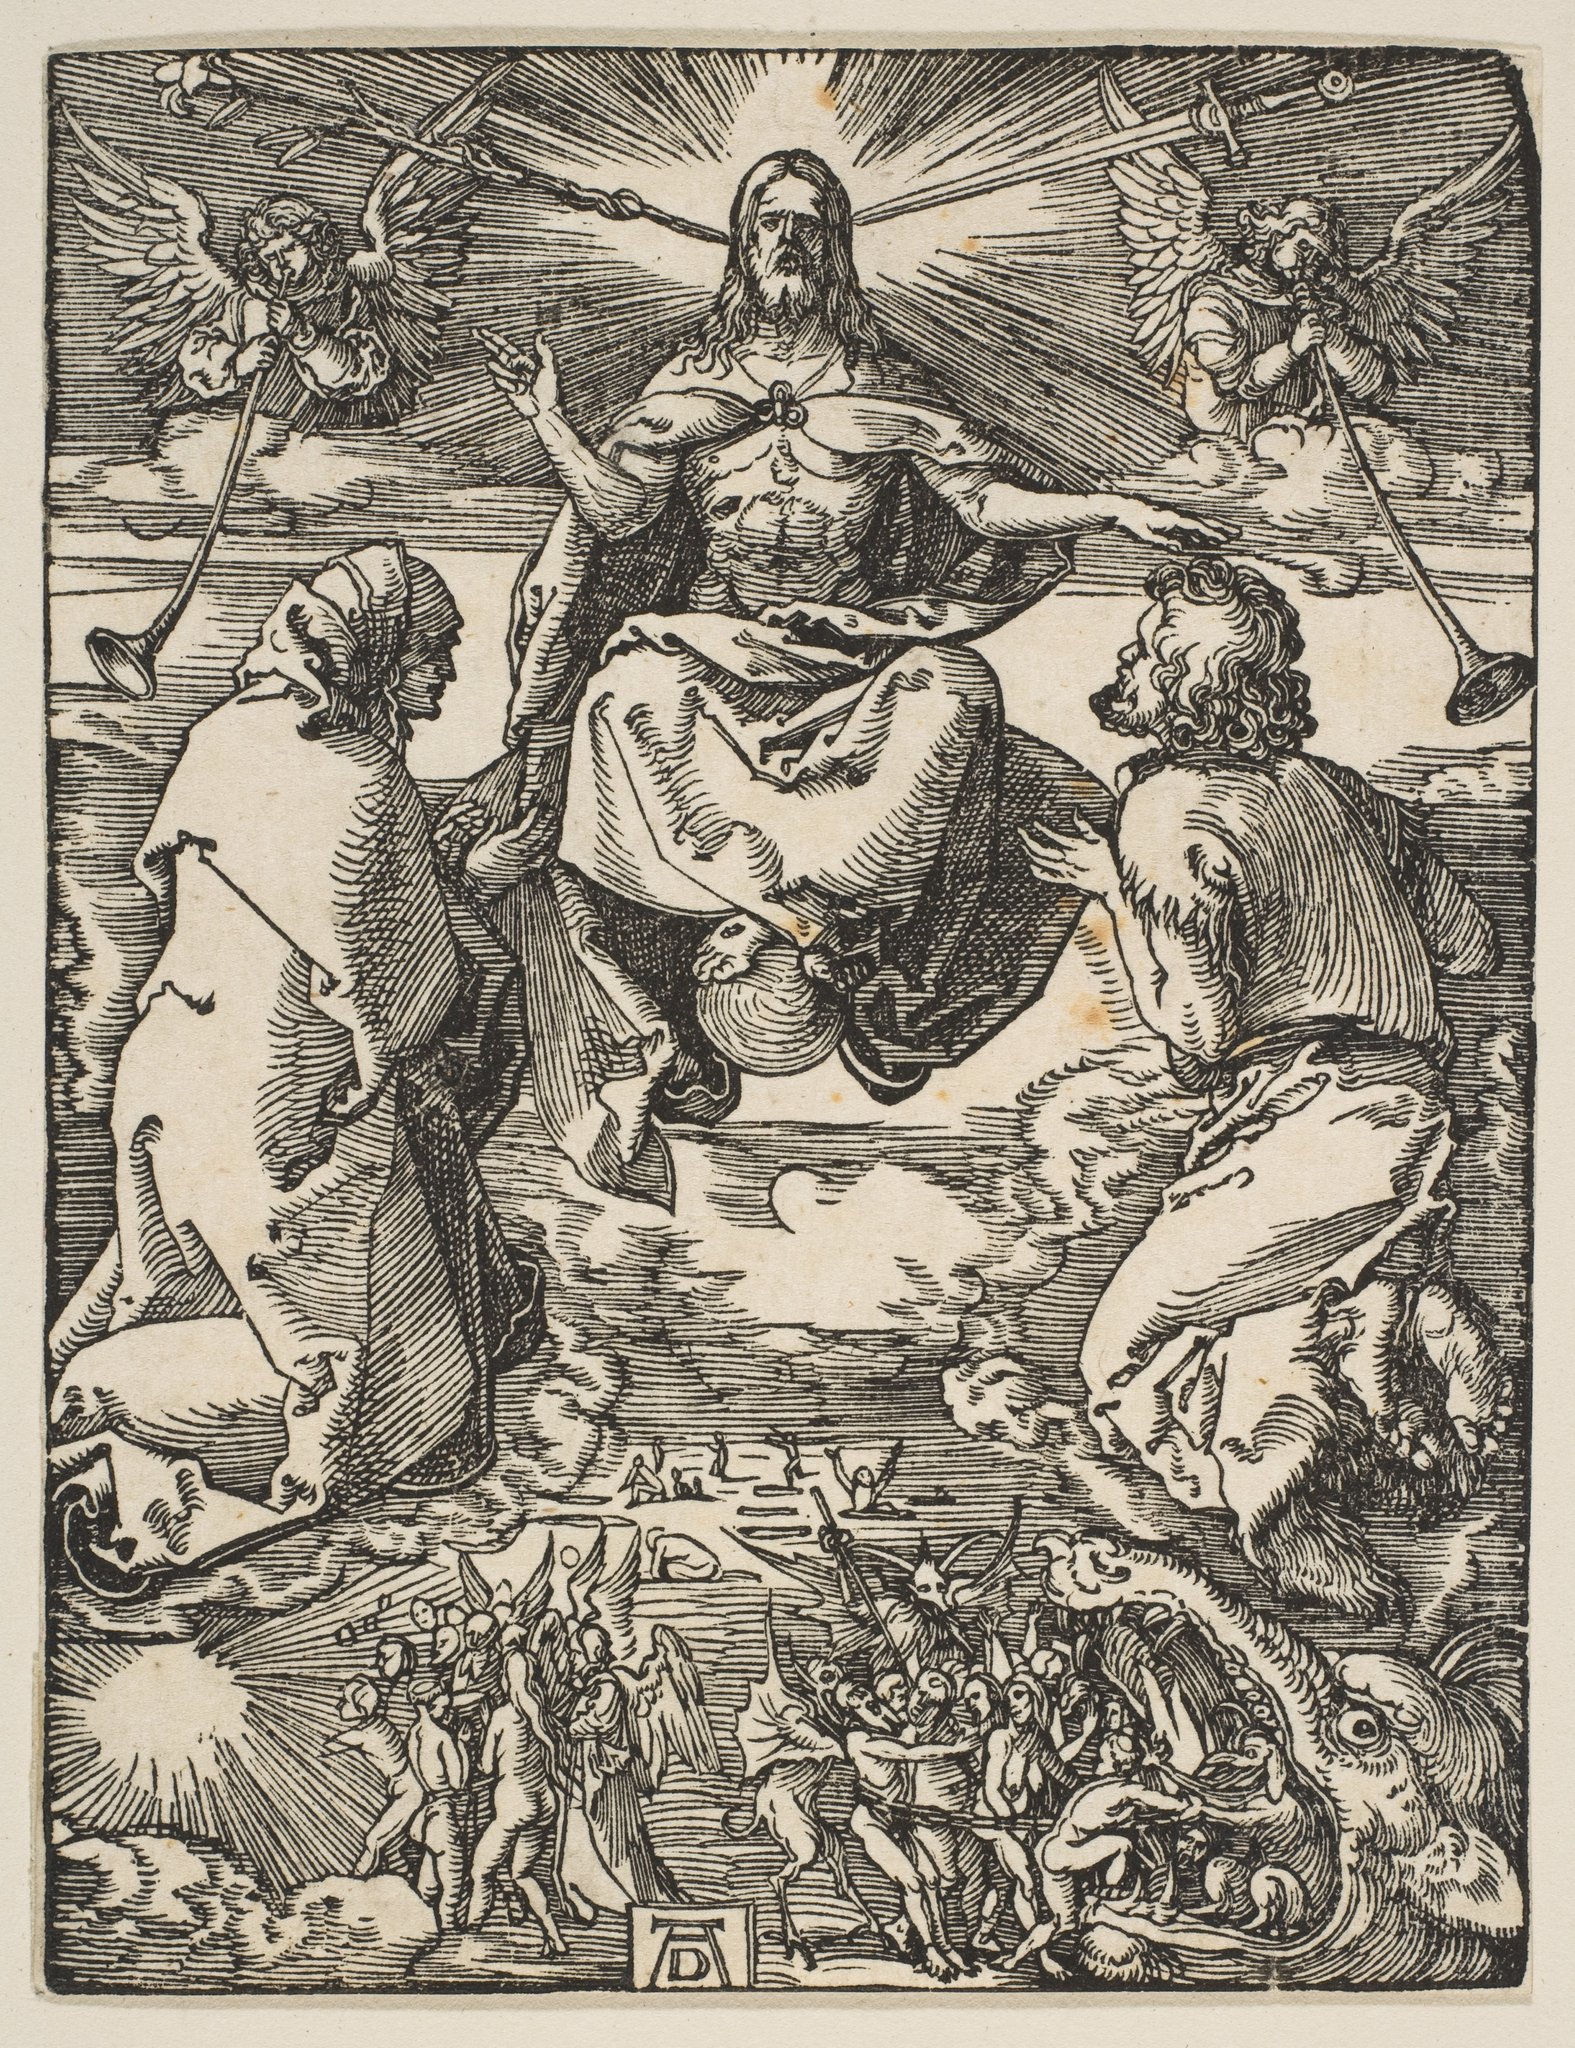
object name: print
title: The Last Judgment, from "The Small Passion"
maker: albrecht dürer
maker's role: artist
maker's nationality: german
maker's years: 1471-1528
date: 1510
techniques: woodcut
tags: angels,christ,last judgement